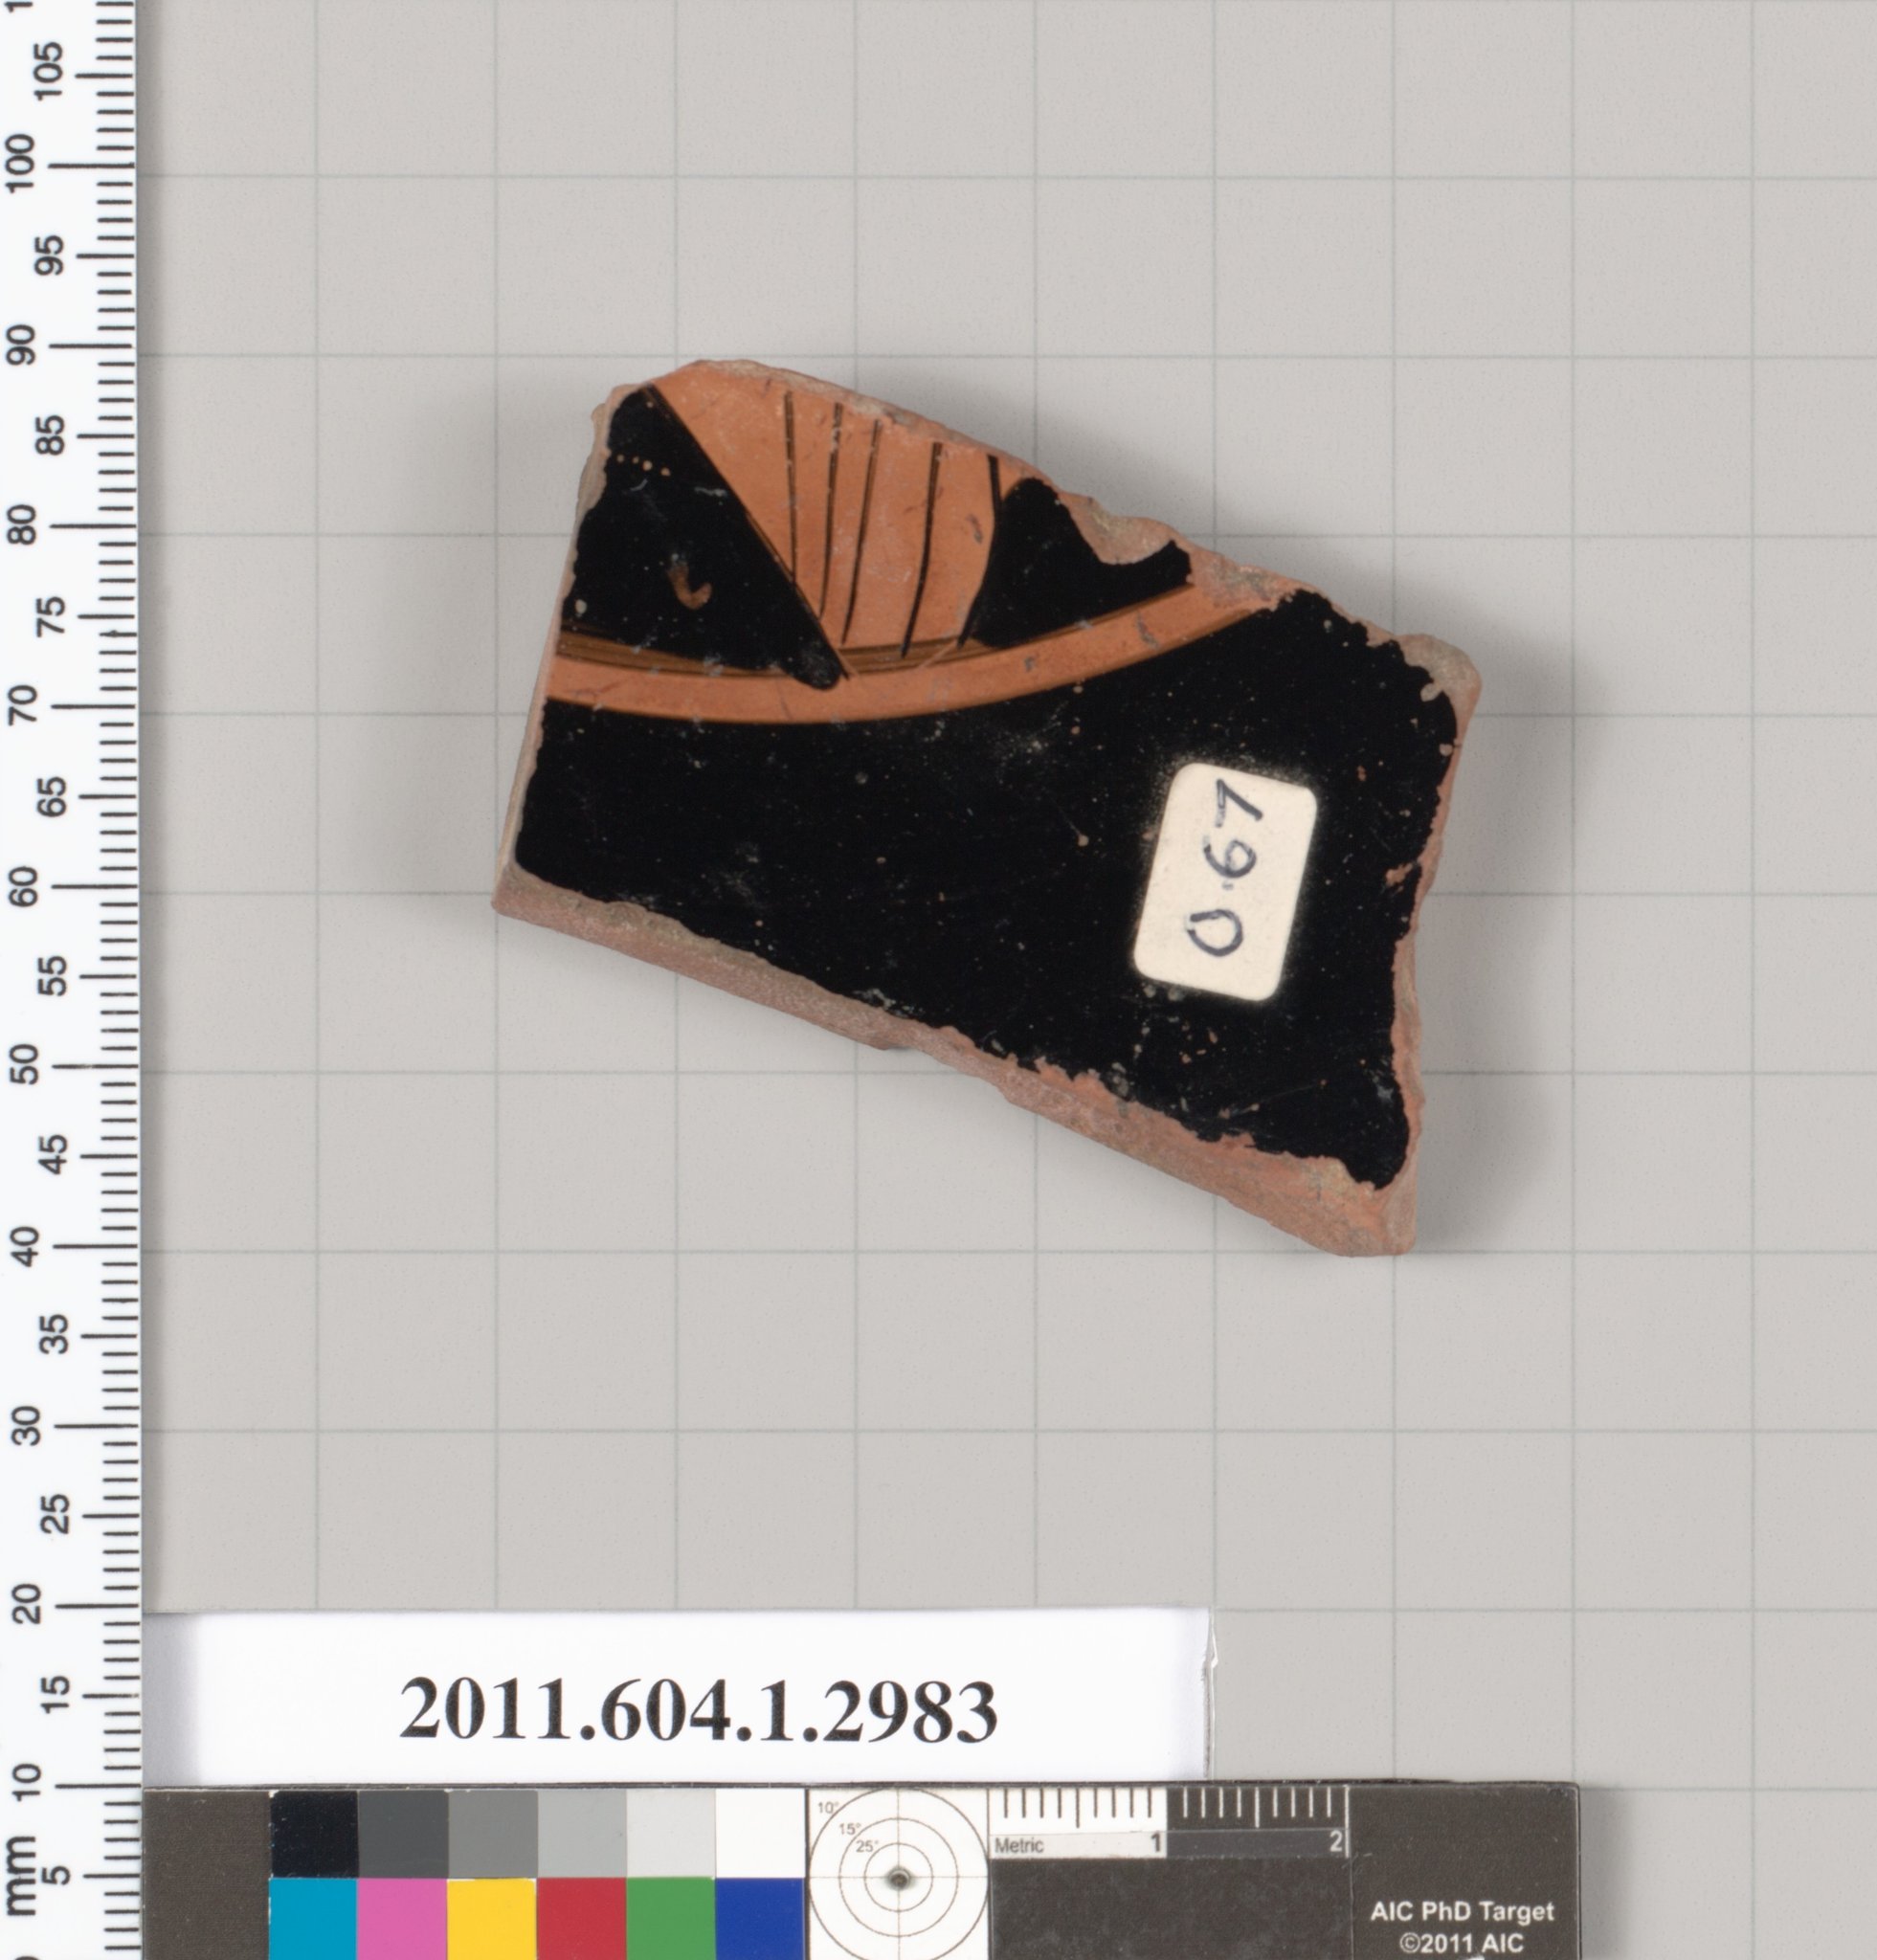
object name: kylix fragment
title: Terracotta fragment of a kylix (drinking cup)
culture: greek, attic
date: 520-500 BCE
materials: terracotta